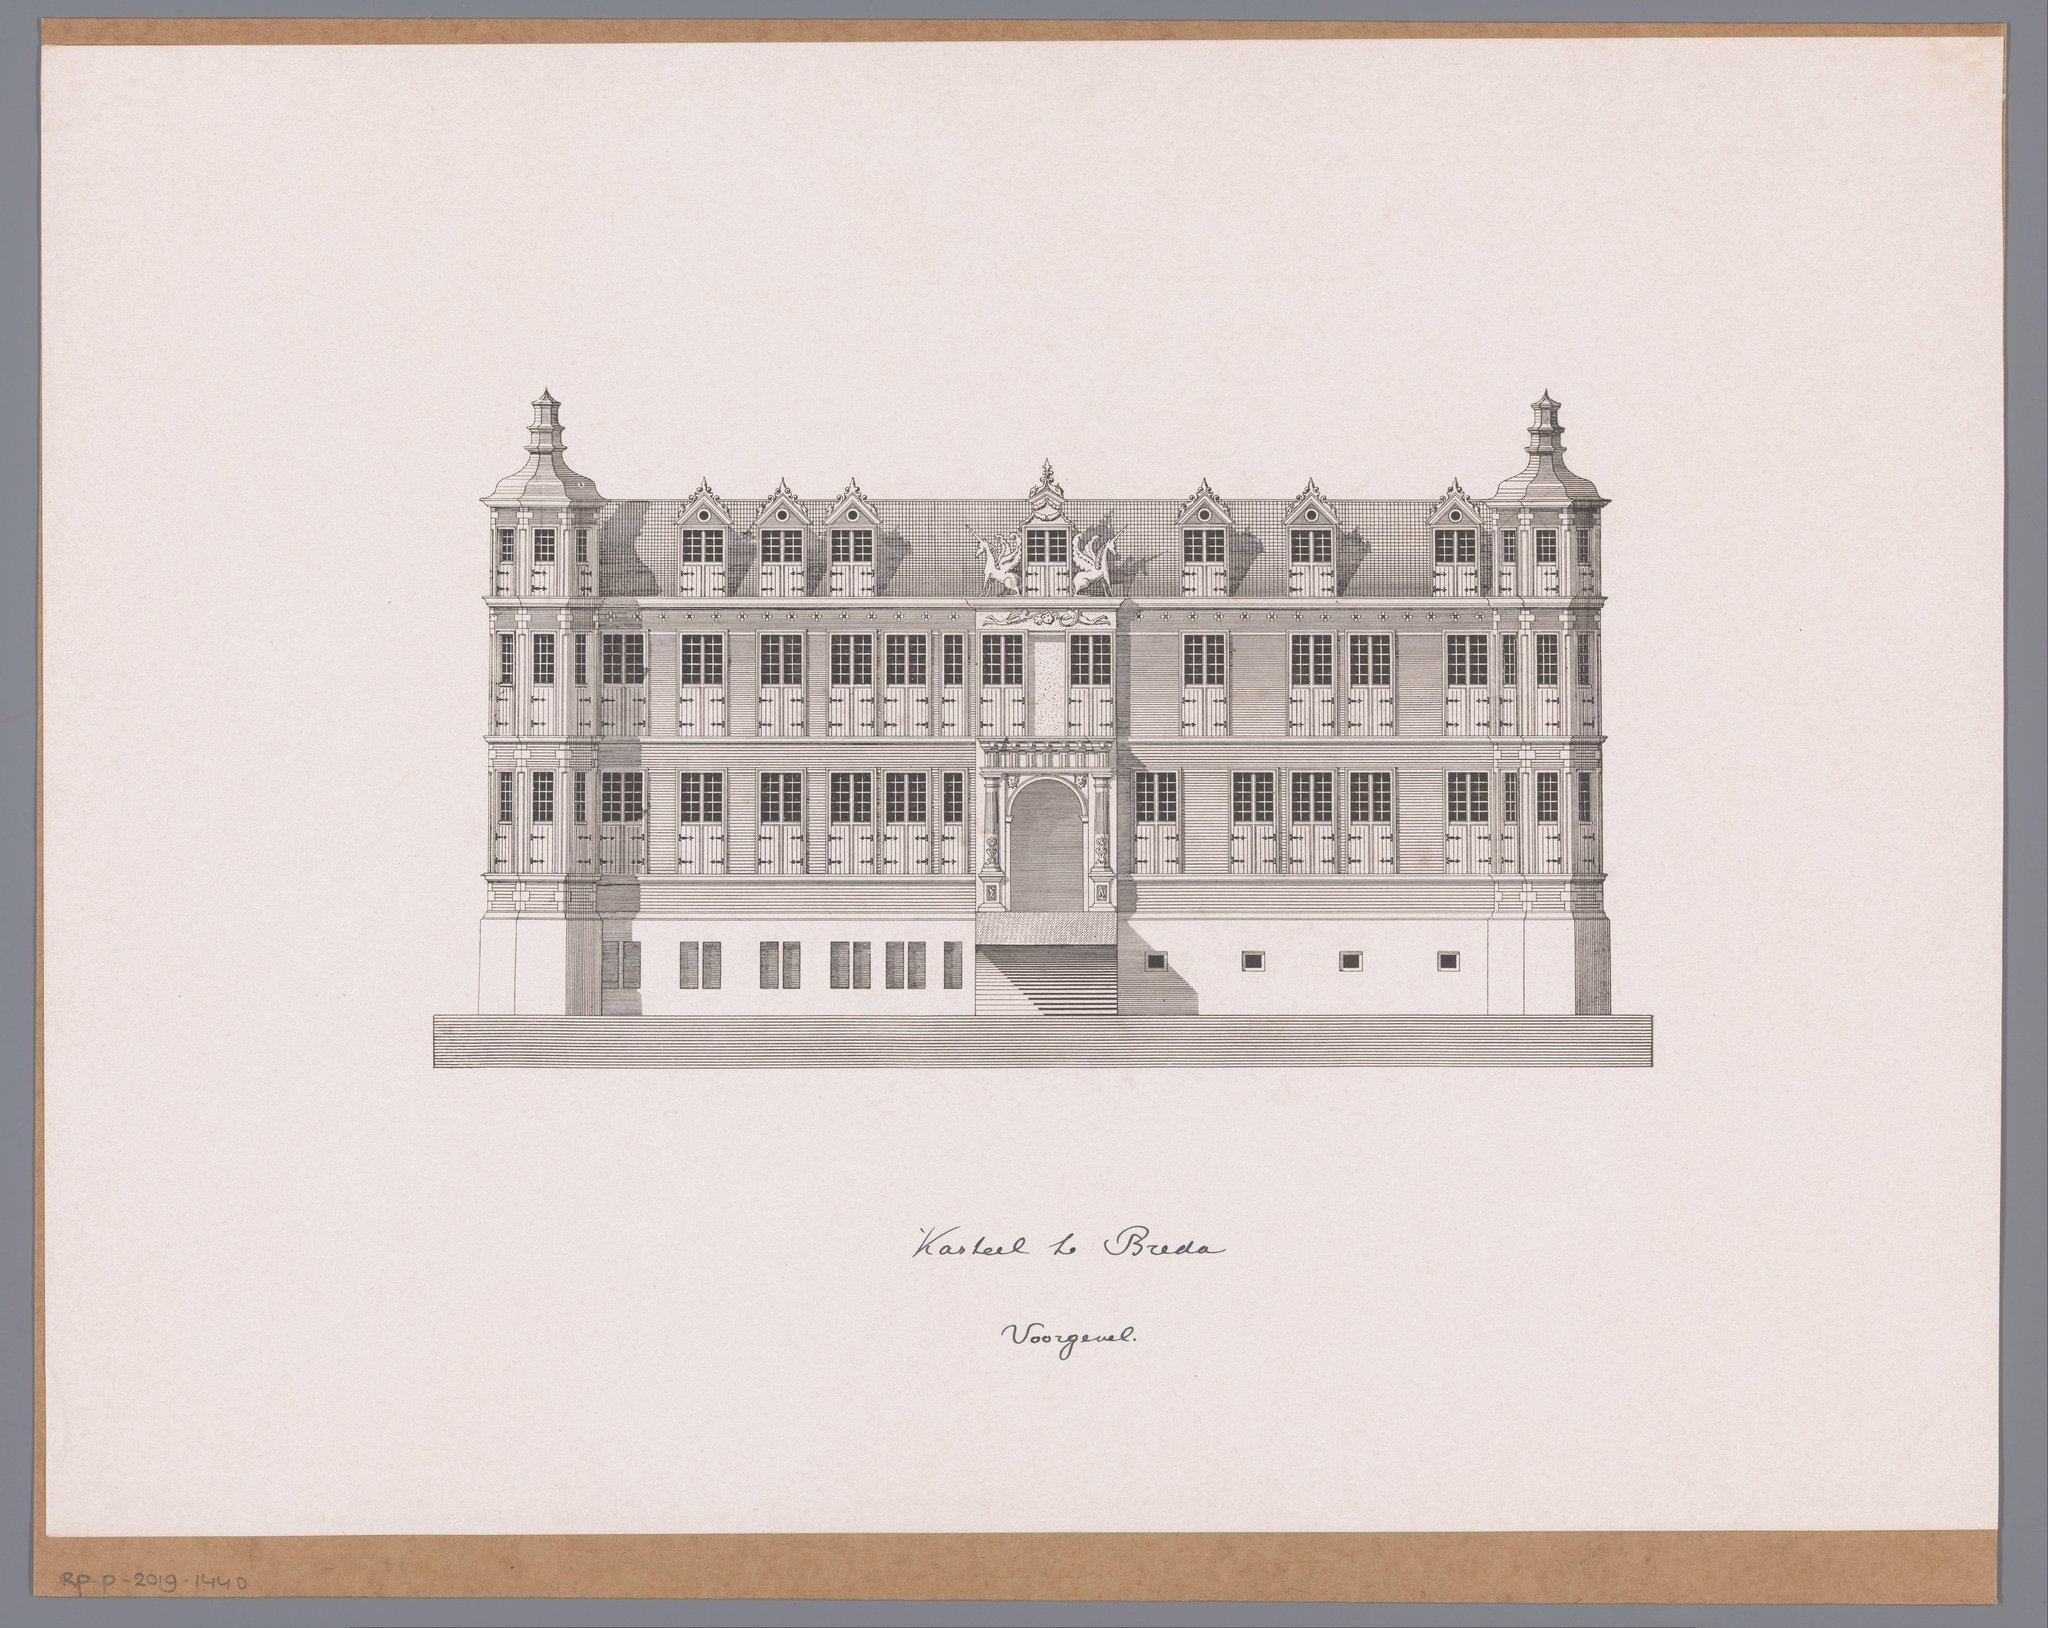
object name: photomechanical print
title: Voorgevel van het Kasteel van Breda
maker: Anonymous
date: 1900-1950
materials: paper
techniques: printing block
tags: townhall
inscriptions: annotation: ‘"Kasteel te Breda / Voorgevel."’